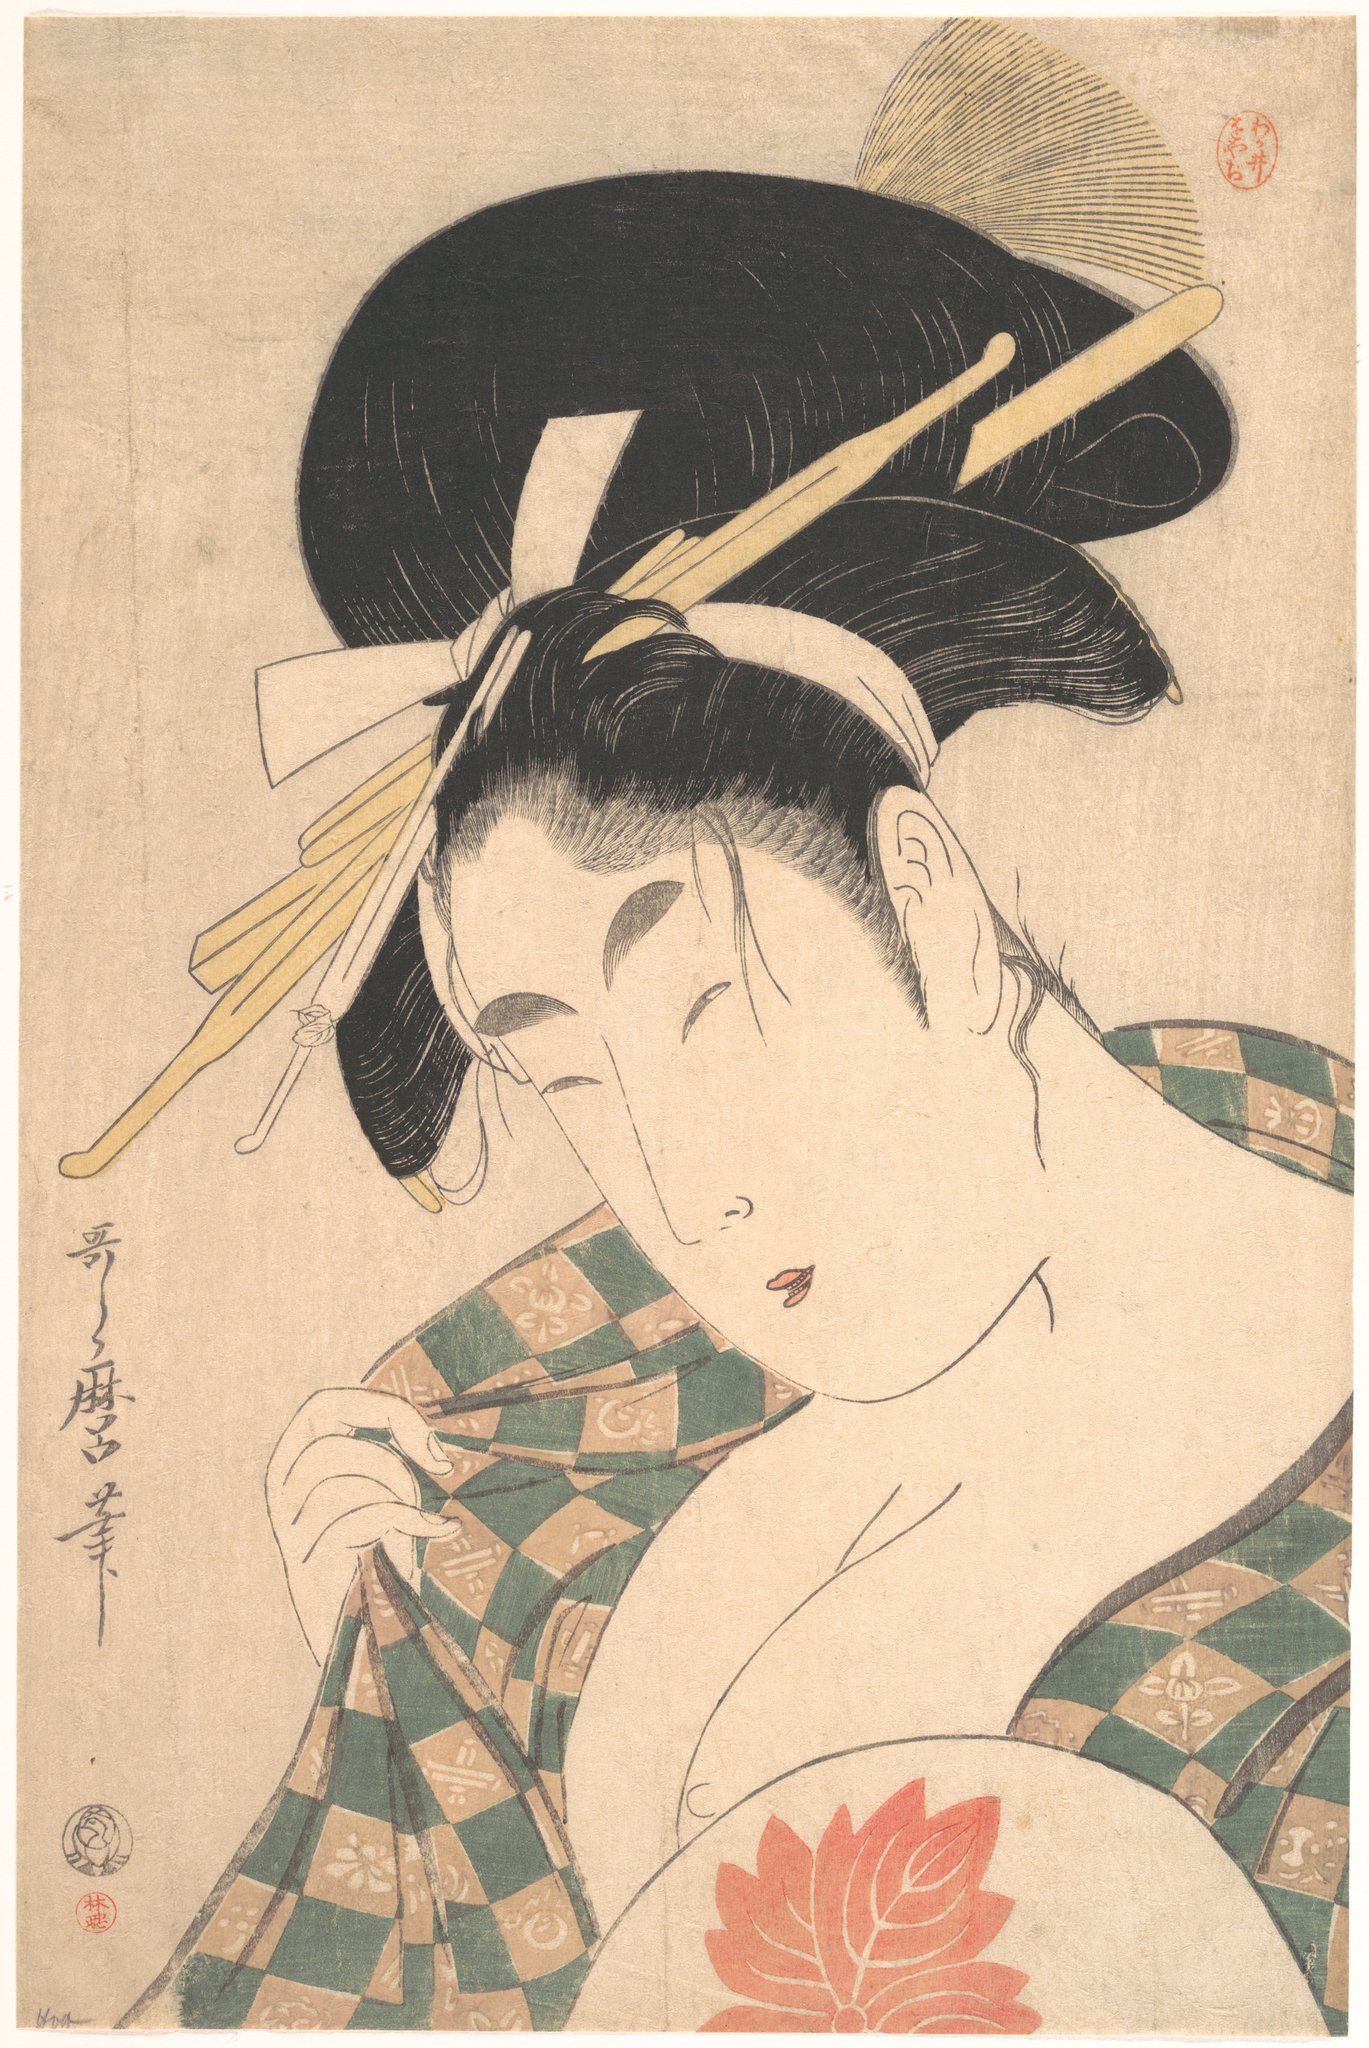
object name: print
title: A Courtesan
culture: japanese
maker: kitagawa utamaro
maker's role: artist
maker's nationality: japanese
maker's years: 1754-1806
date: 1754-1806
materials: ink, paper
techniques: woodblock print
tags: women